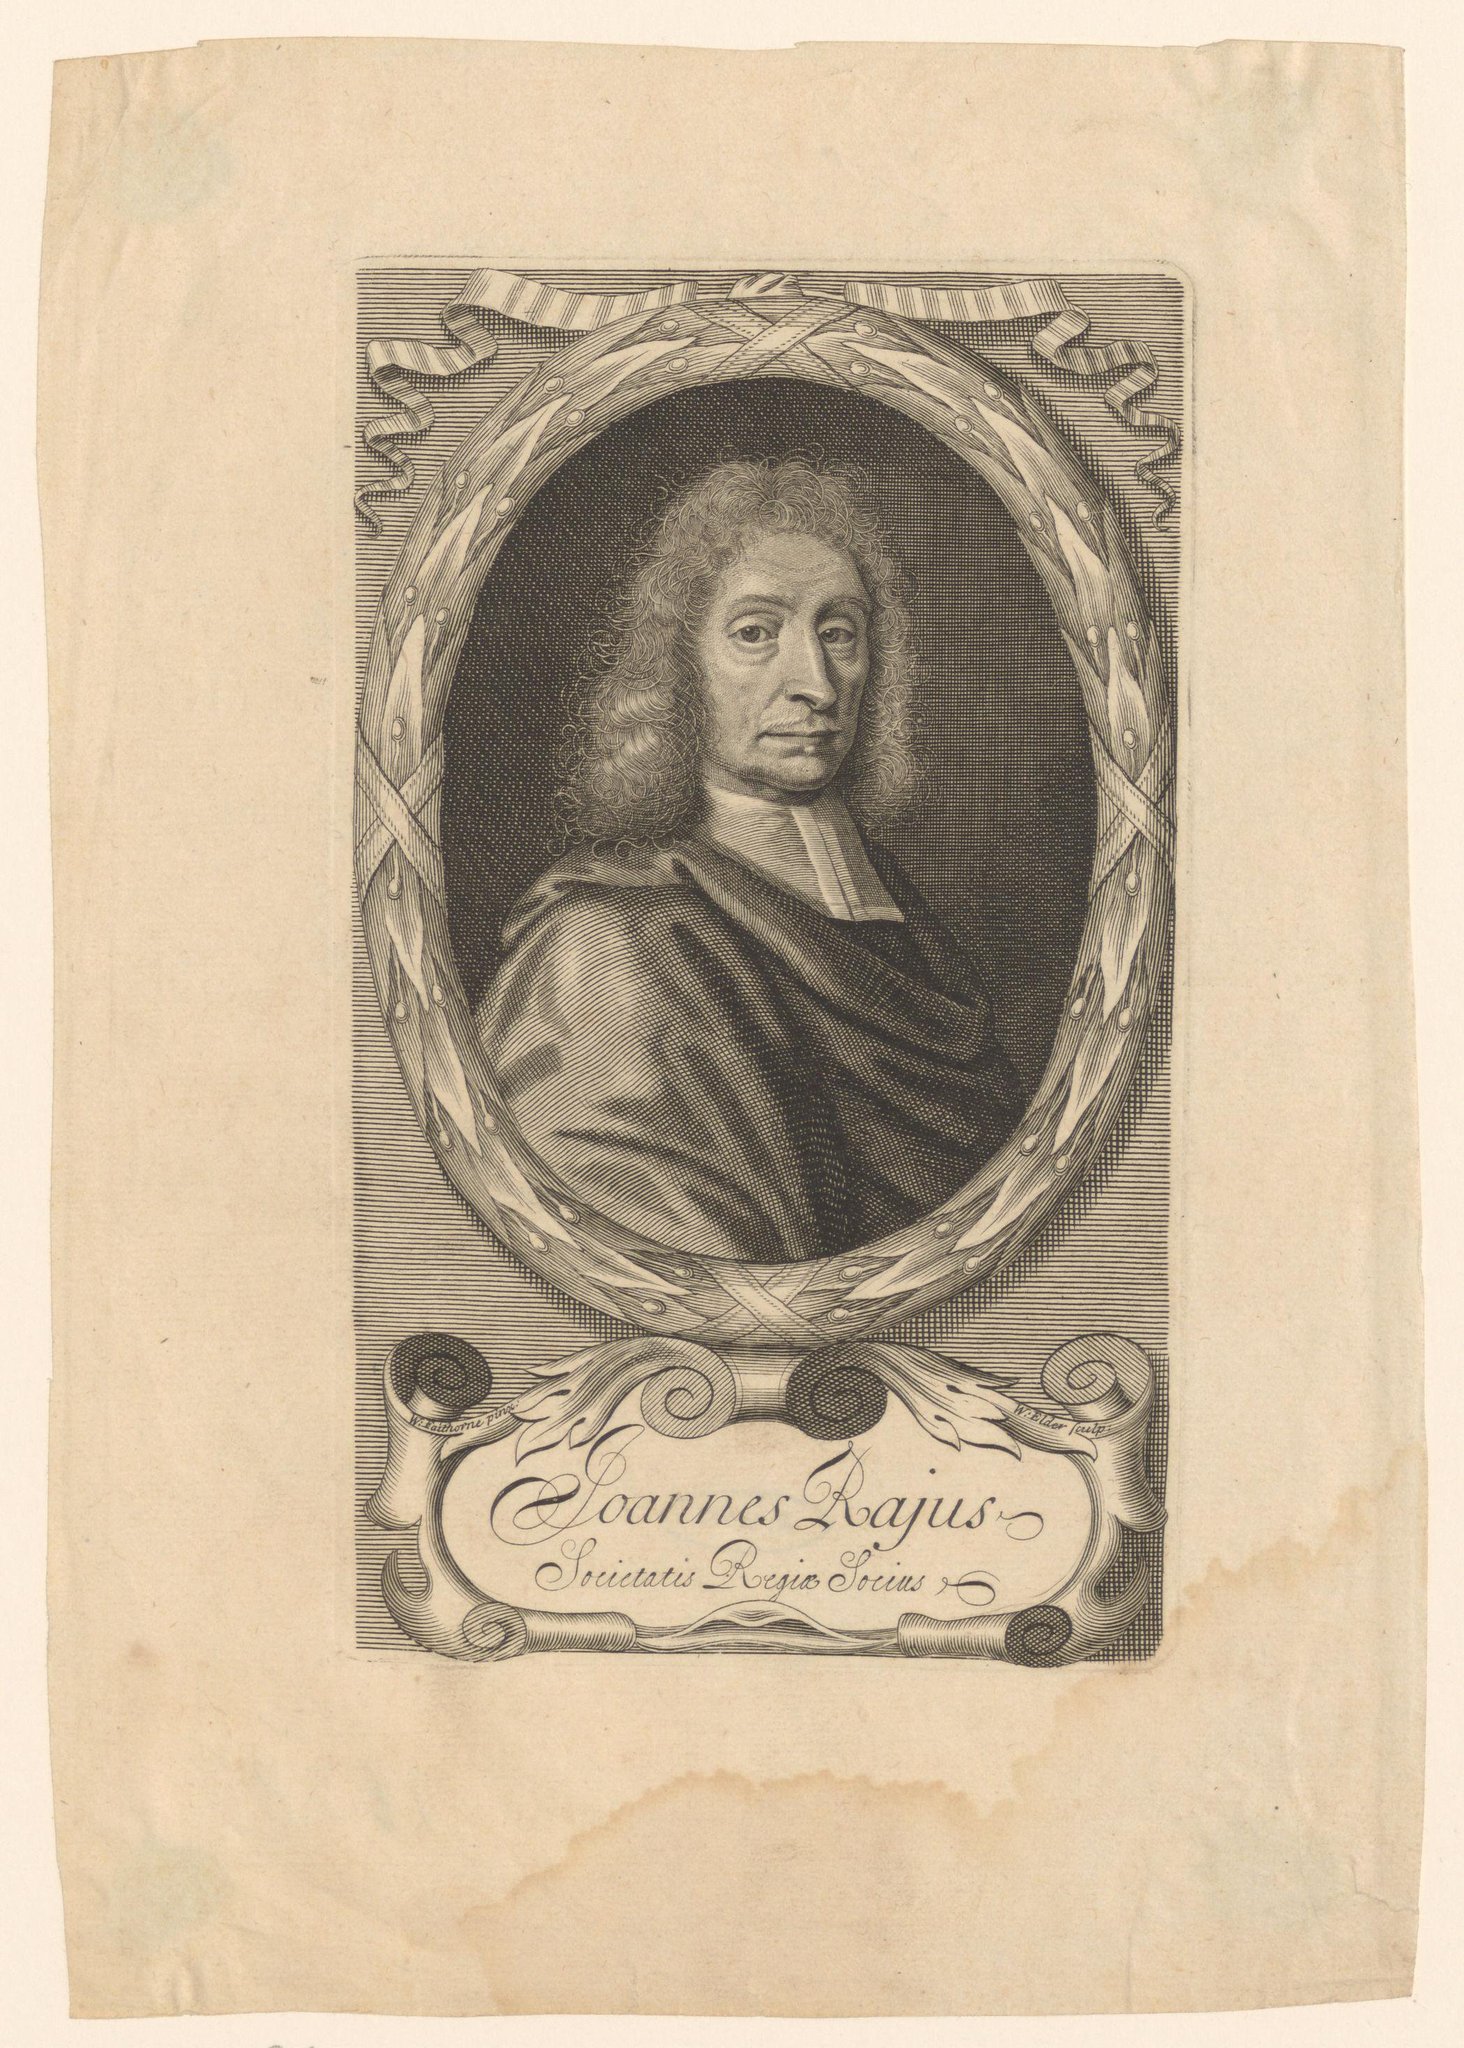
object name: print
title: Ioannes de la Quintinye Regiorum Hortorum Culturae Praefectus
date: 1680-1700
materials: paper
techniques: engraving, etching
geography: london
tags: historical persons, portrait, self-portrait of architect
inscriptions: collector's mark: Lugt 2228